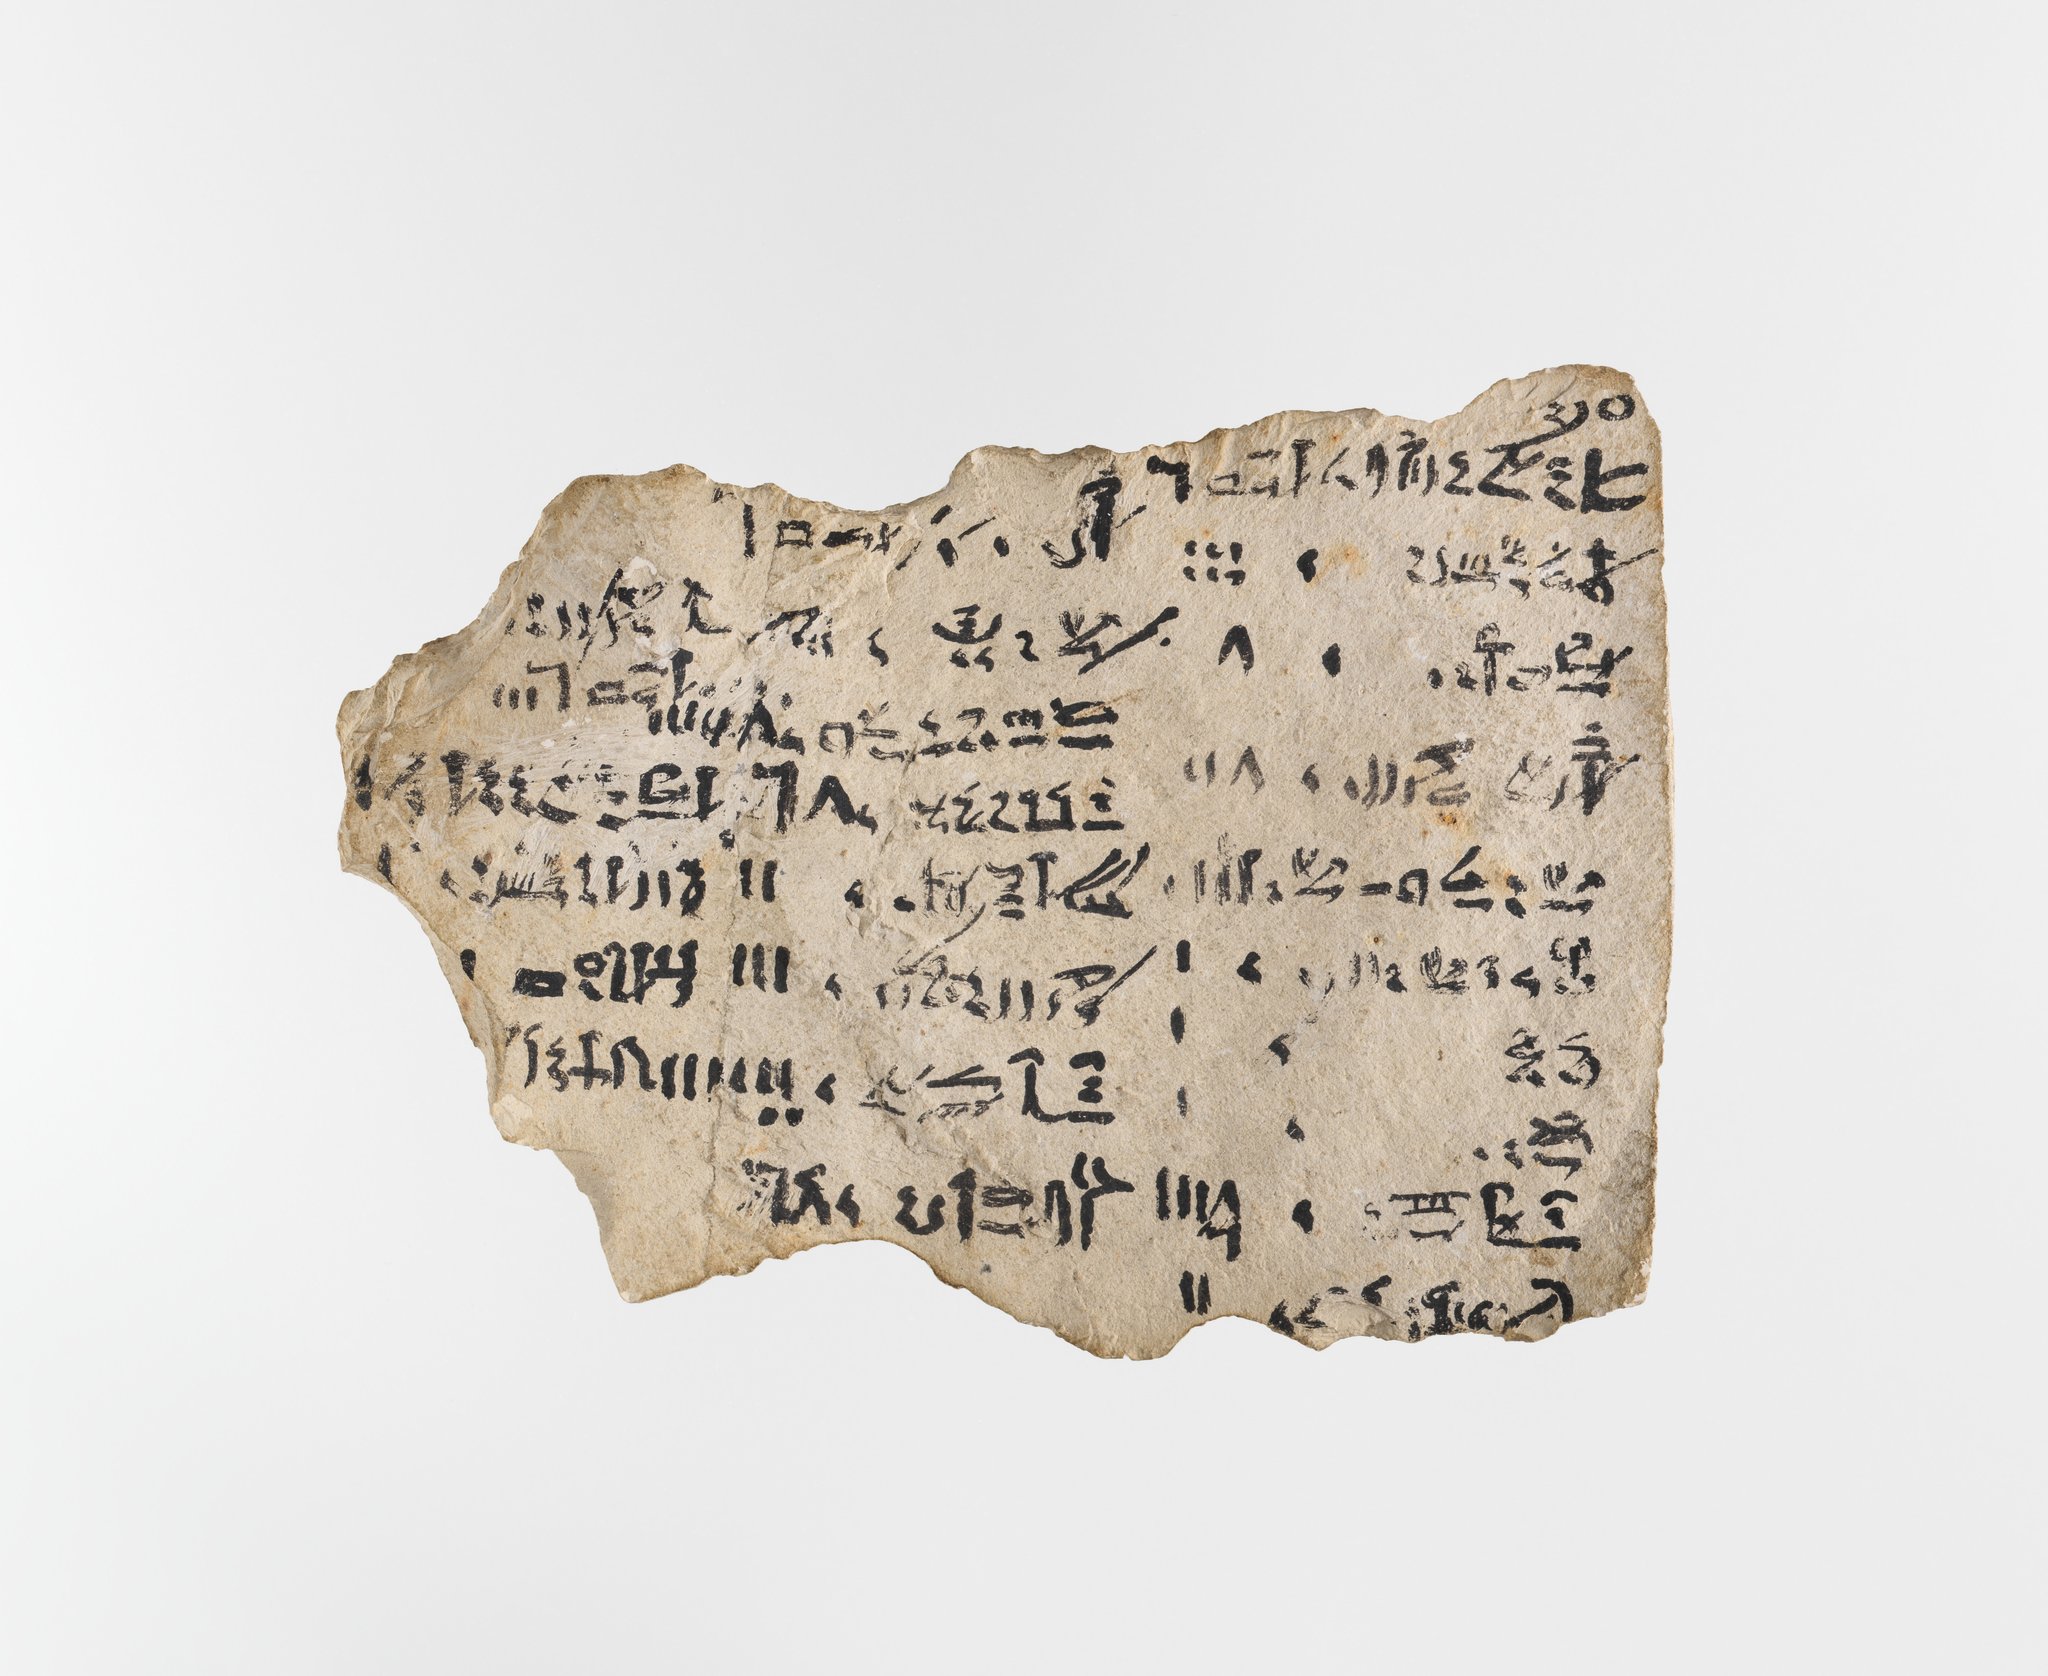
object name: ostracon, hieratic, account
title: Ostracon with hieratic inscription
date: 1295-525 BCE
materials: ink, limestone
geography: egypt